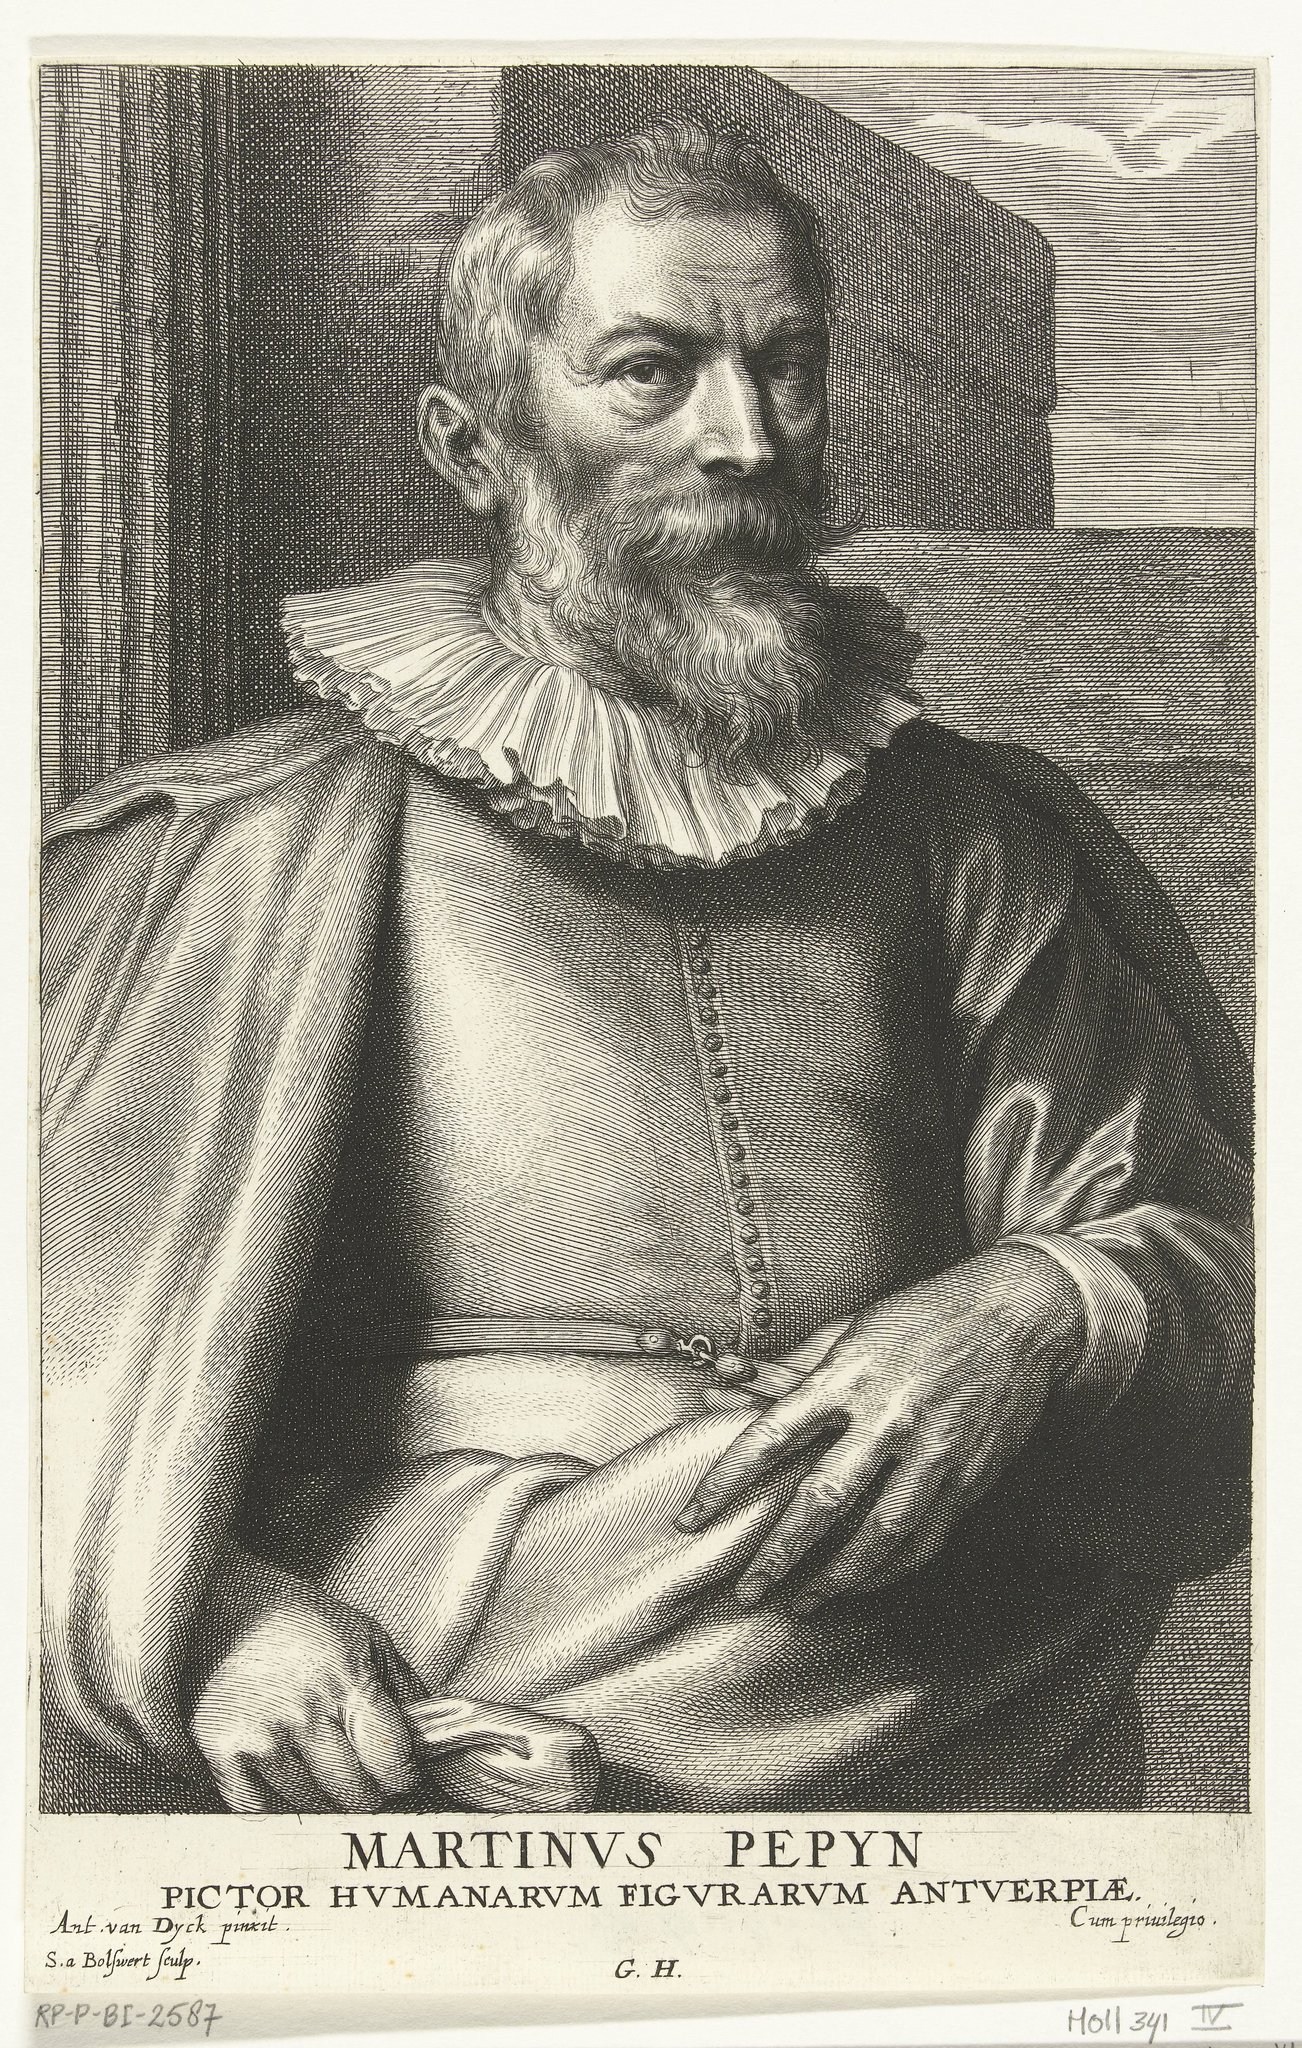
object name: print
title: Martinvs Pepyn pictor hvmanarvm figvrarvm Antverpiae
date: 1596-1659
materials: paper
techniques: engraving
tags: artist, historical persons, portrait, self-portrait of painter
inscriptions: collector's mark: Lugt 240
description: Prent naar schilderij van Anthony van Dyck.